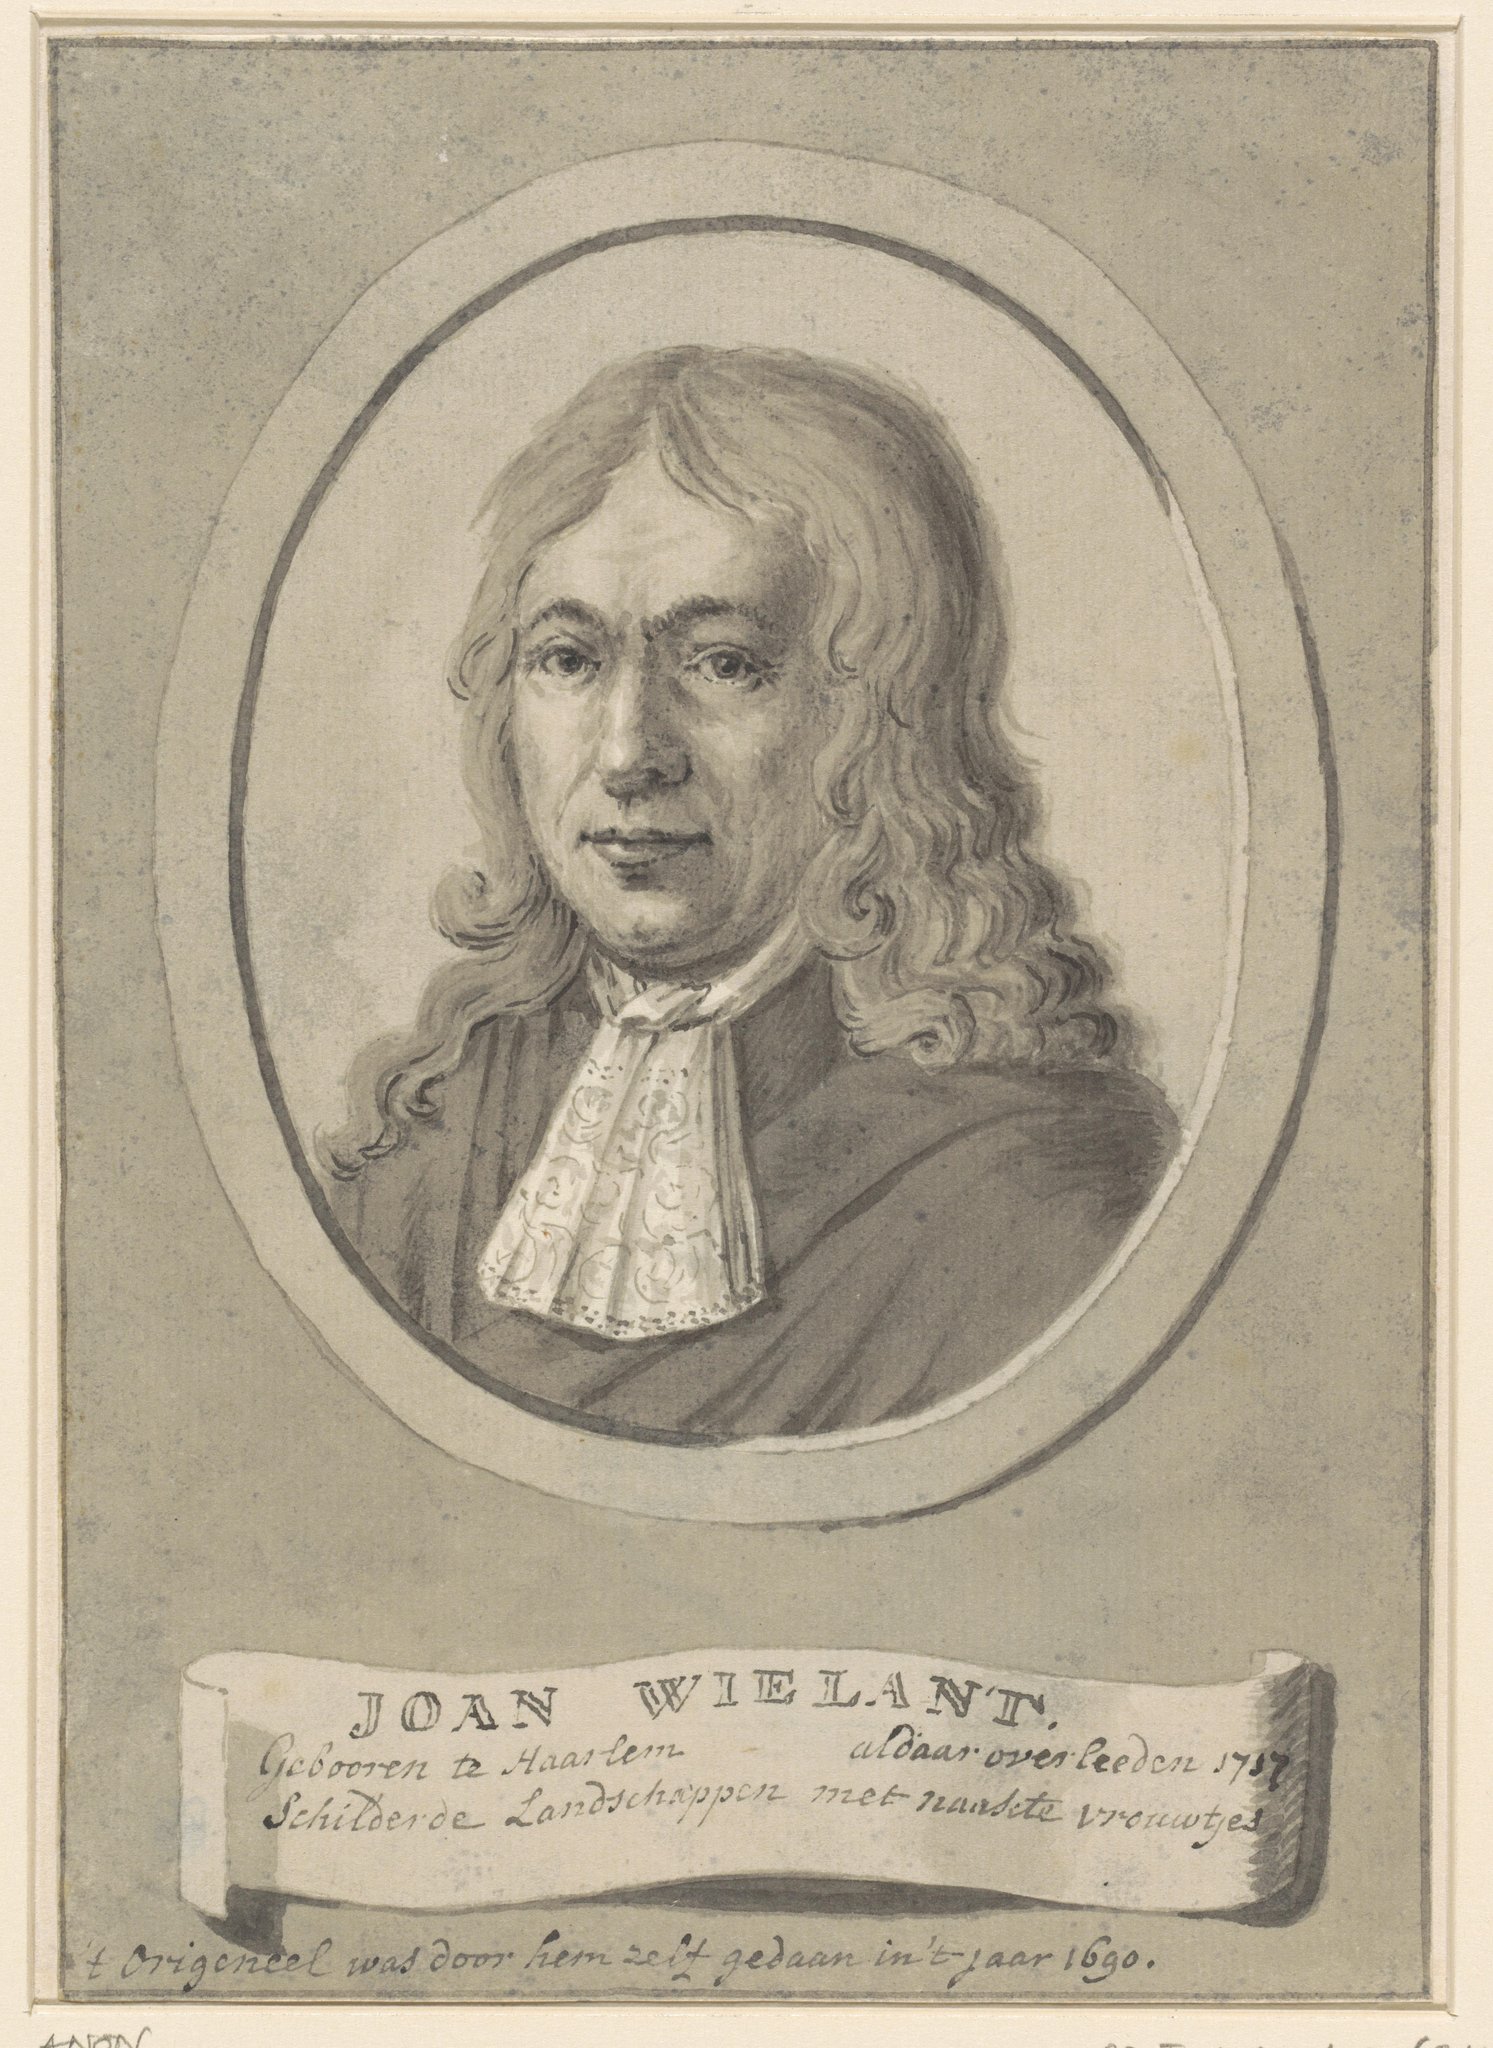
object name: drawing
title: Portret van Joan Wielant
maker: Anonymous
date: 1700-1900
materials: ink, paper, pencil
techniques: brush, pen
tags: painter, joan wielant, historical persons, portrait, self-portrait of painter, portrait, self-portrait of artist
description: Kopie naar zelfportret van Joan Wielant.